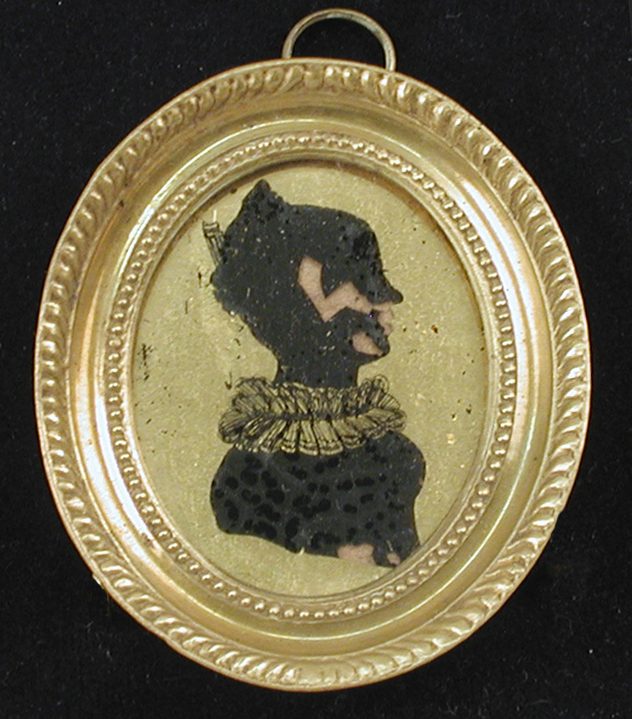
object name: medallion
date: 1801-1900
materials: glass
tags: profiles,women